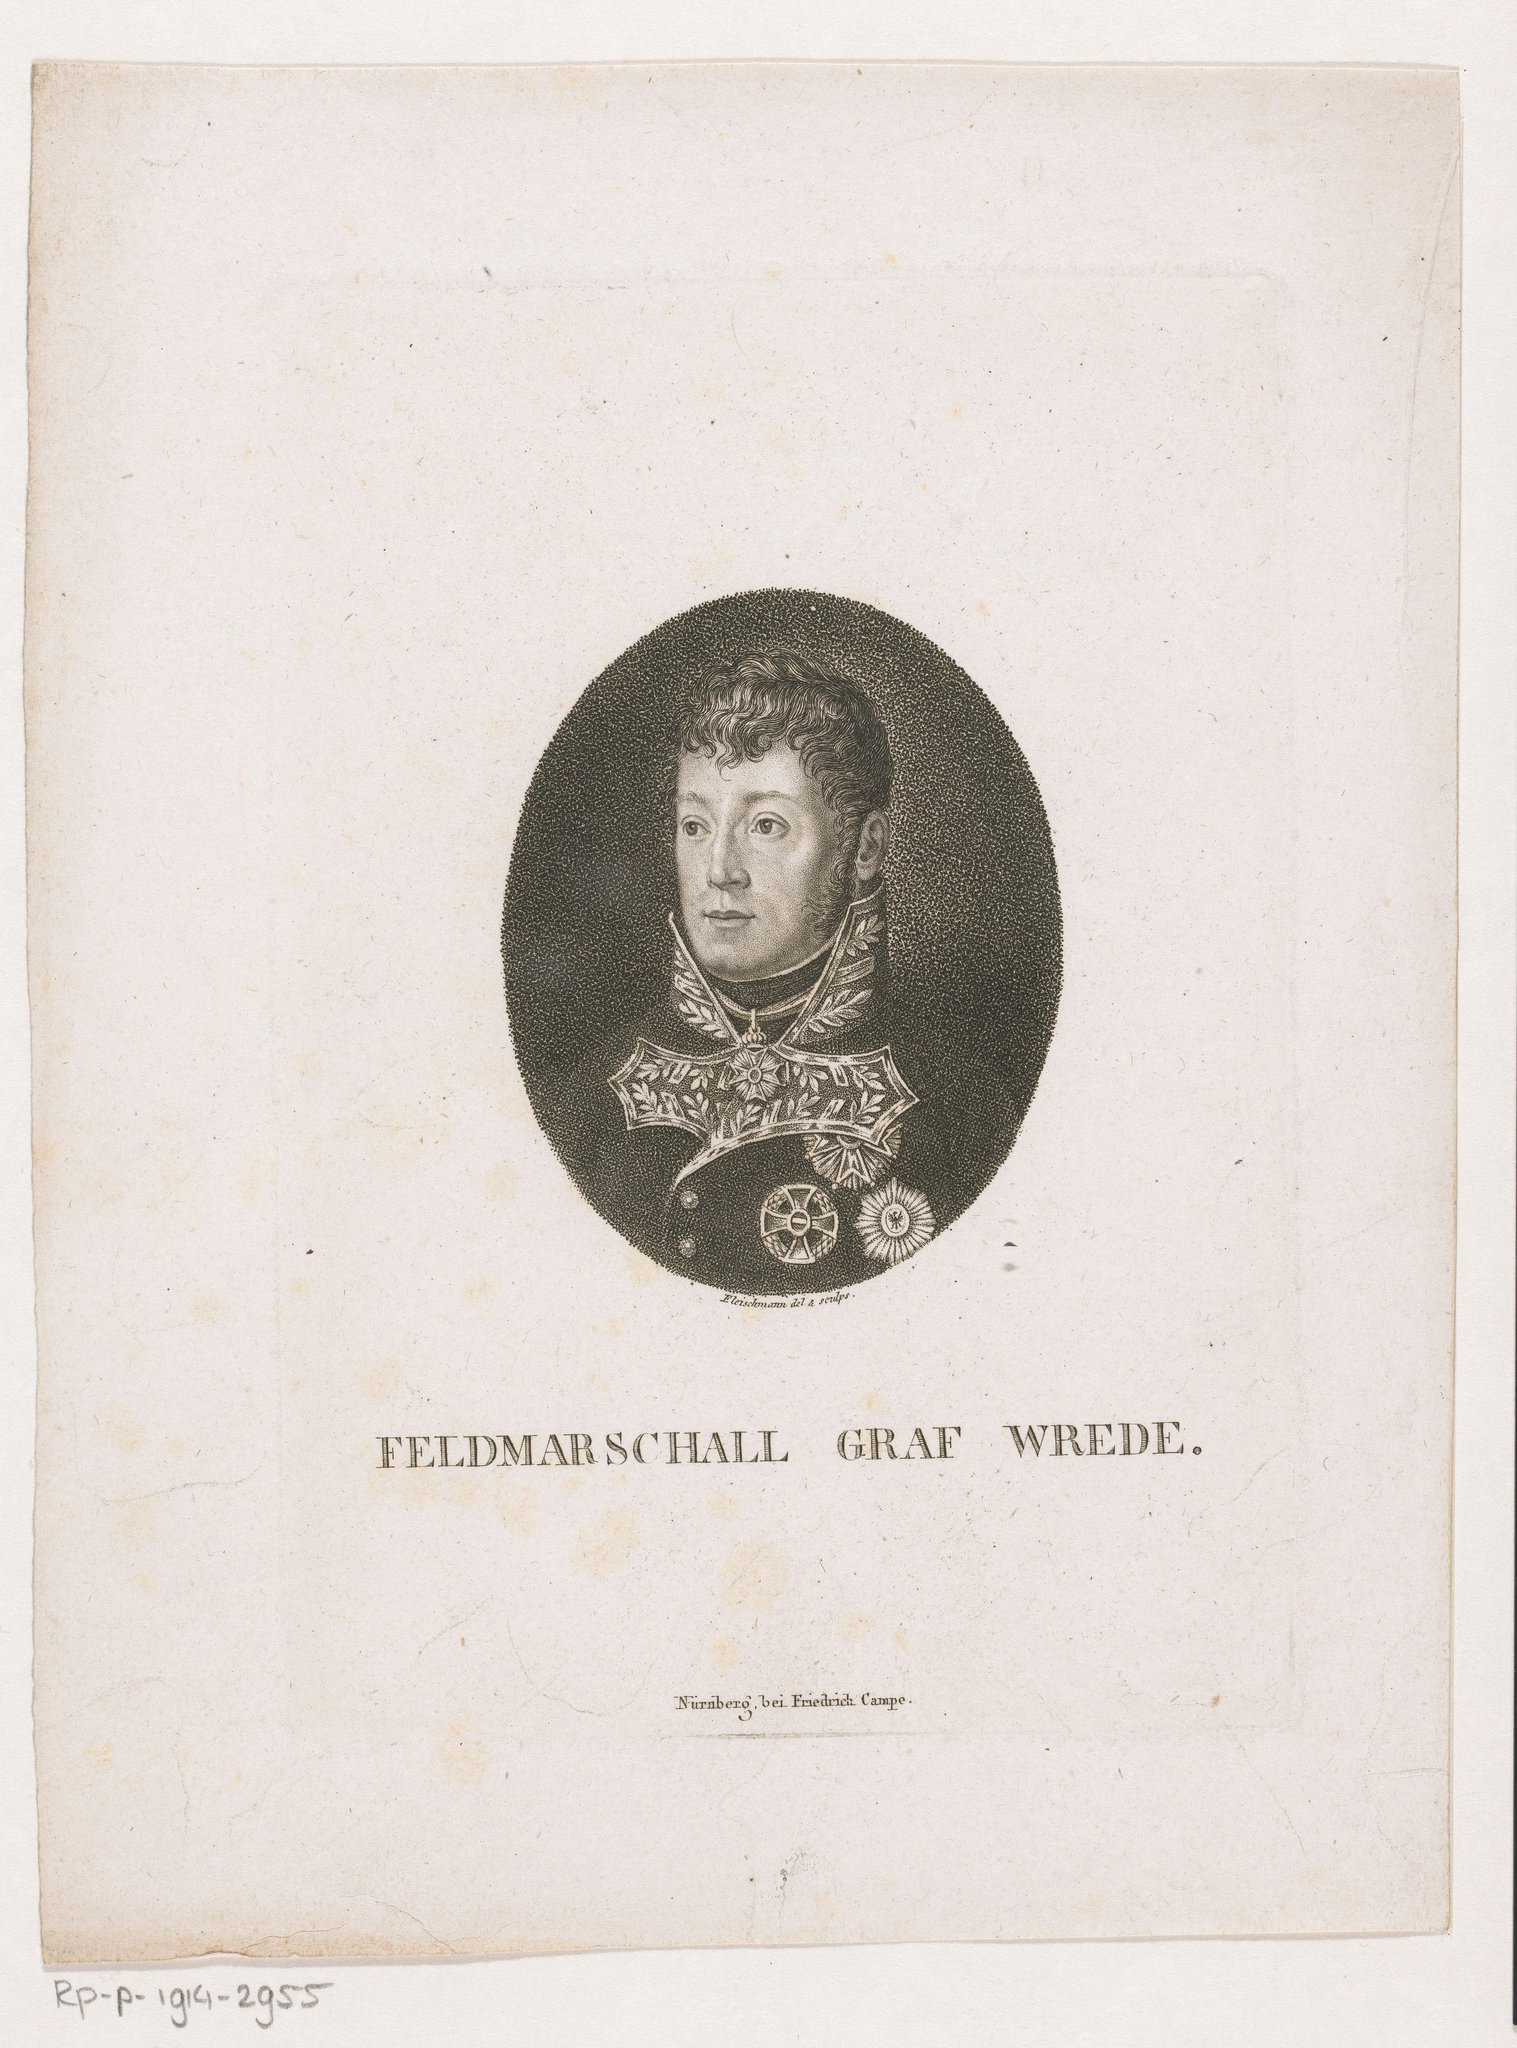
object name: print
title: Portret van Carl Philipp von Wrede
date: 1801-1834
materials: paper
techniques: engraving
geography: nuremberg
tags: knighthood order (with name) - insignia of a knighthood order, e.g.: badge, chain (with name of order), knighthood order, historical persons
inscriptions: collector's mark: Lugt 2228